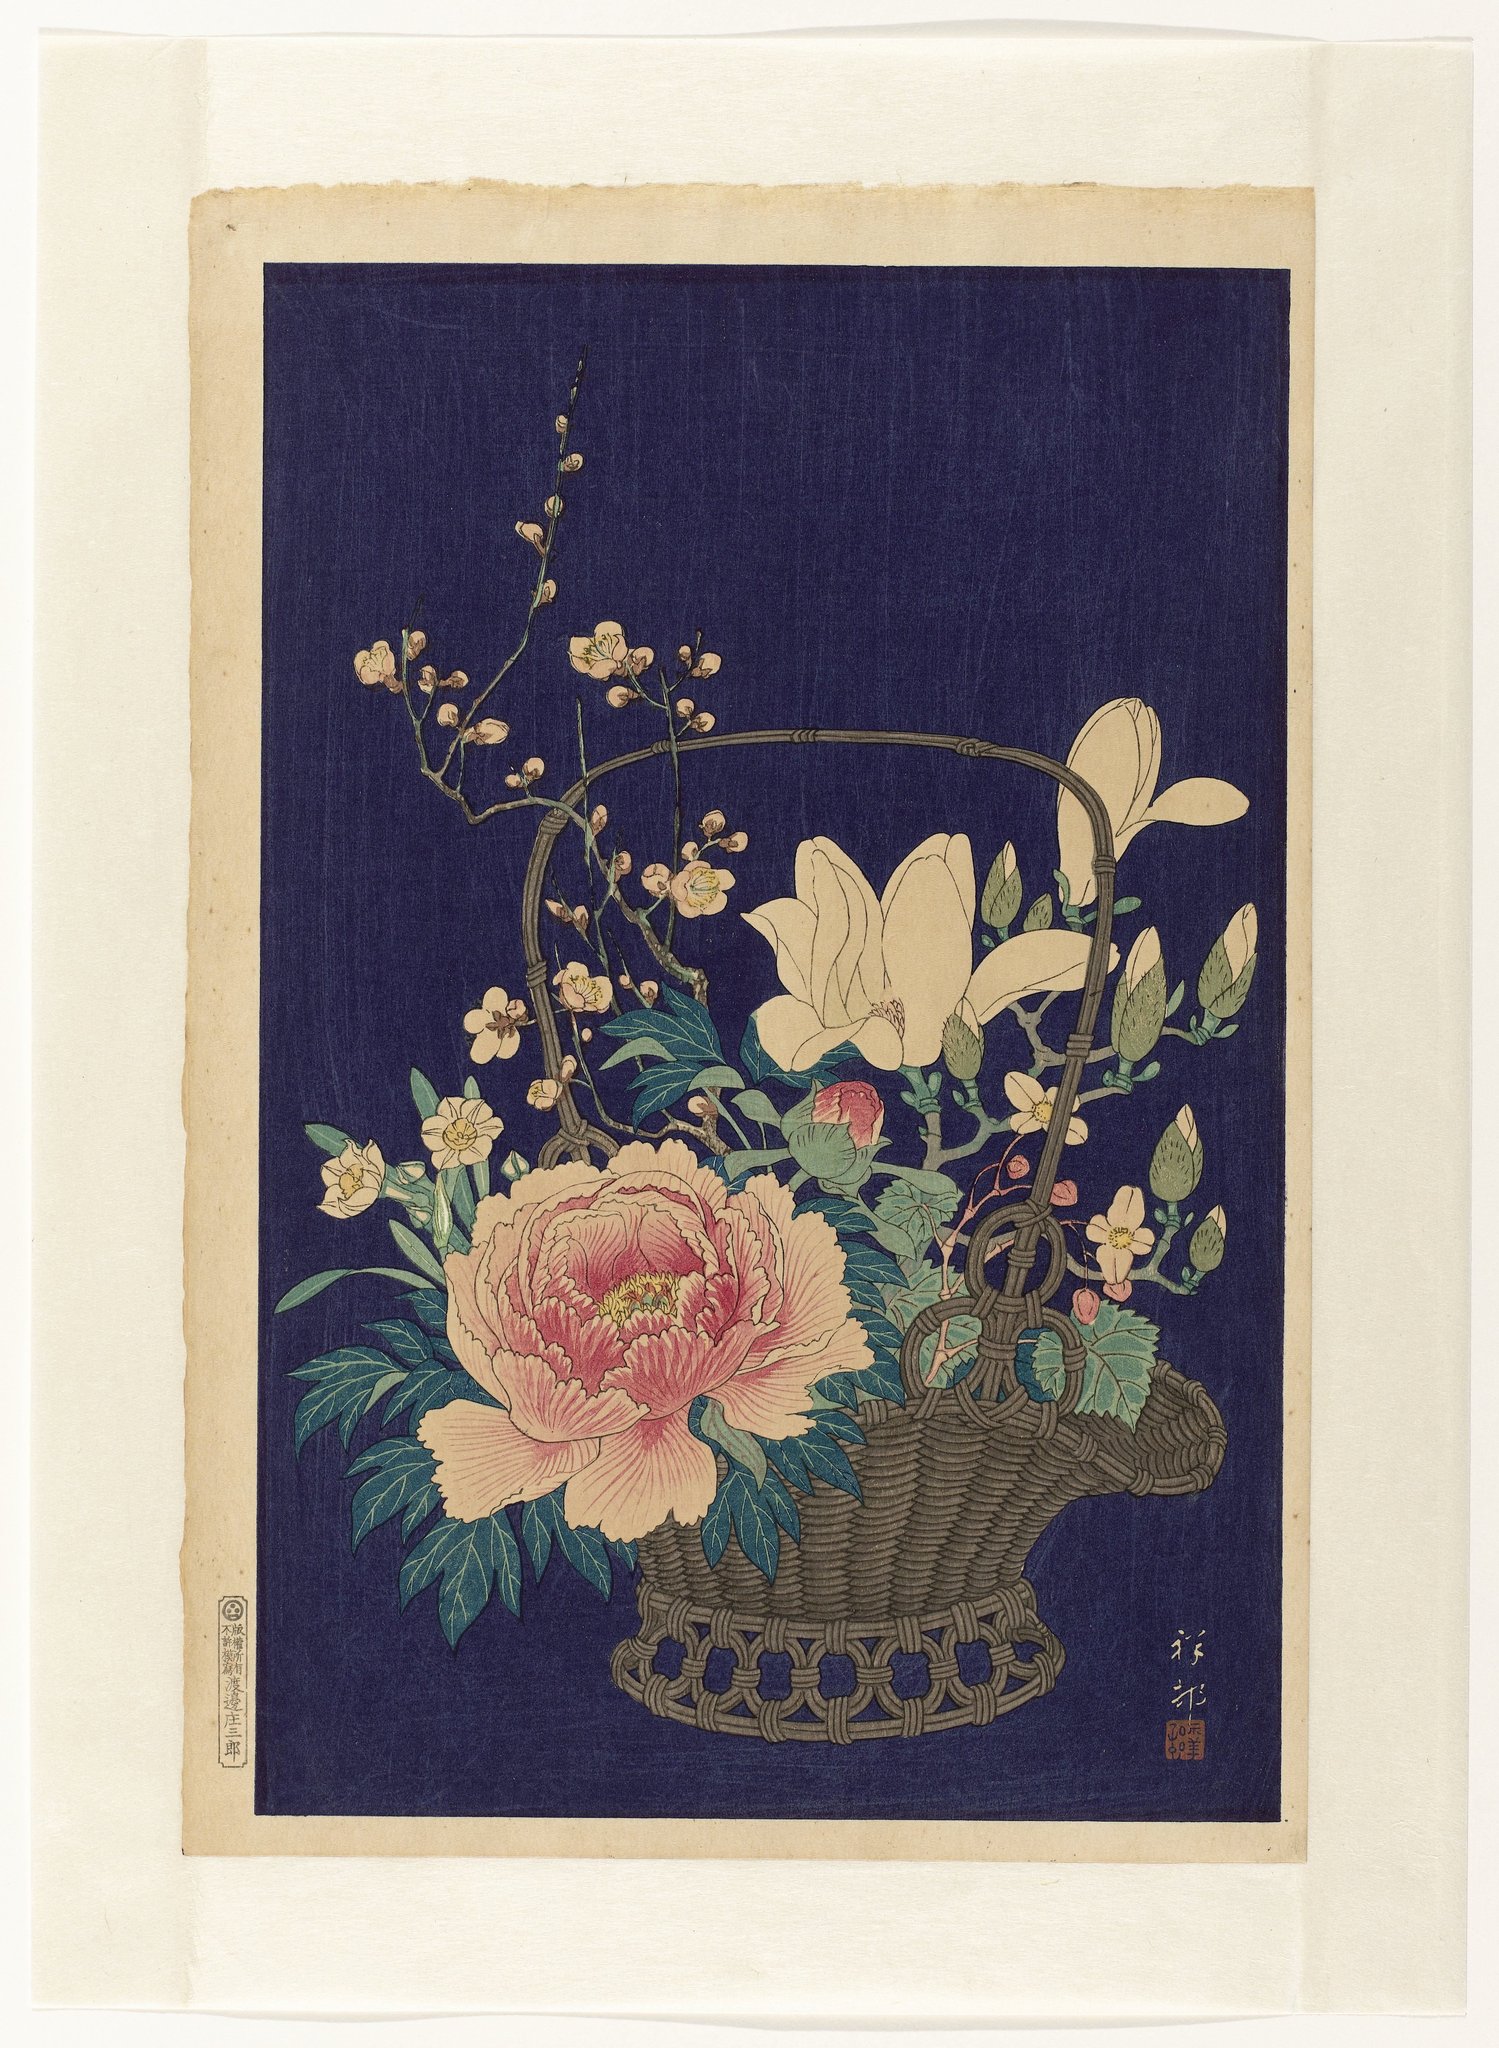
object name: print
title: Bamboo Flowerbasket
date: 1932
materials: paper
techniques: blind stamped, woodcut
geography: japan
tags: bunch of flowers ~ ornament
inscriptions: date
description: Bamboe bloemenmand met hengsel, met magnolia, pioenroos en pruimenbloesem.